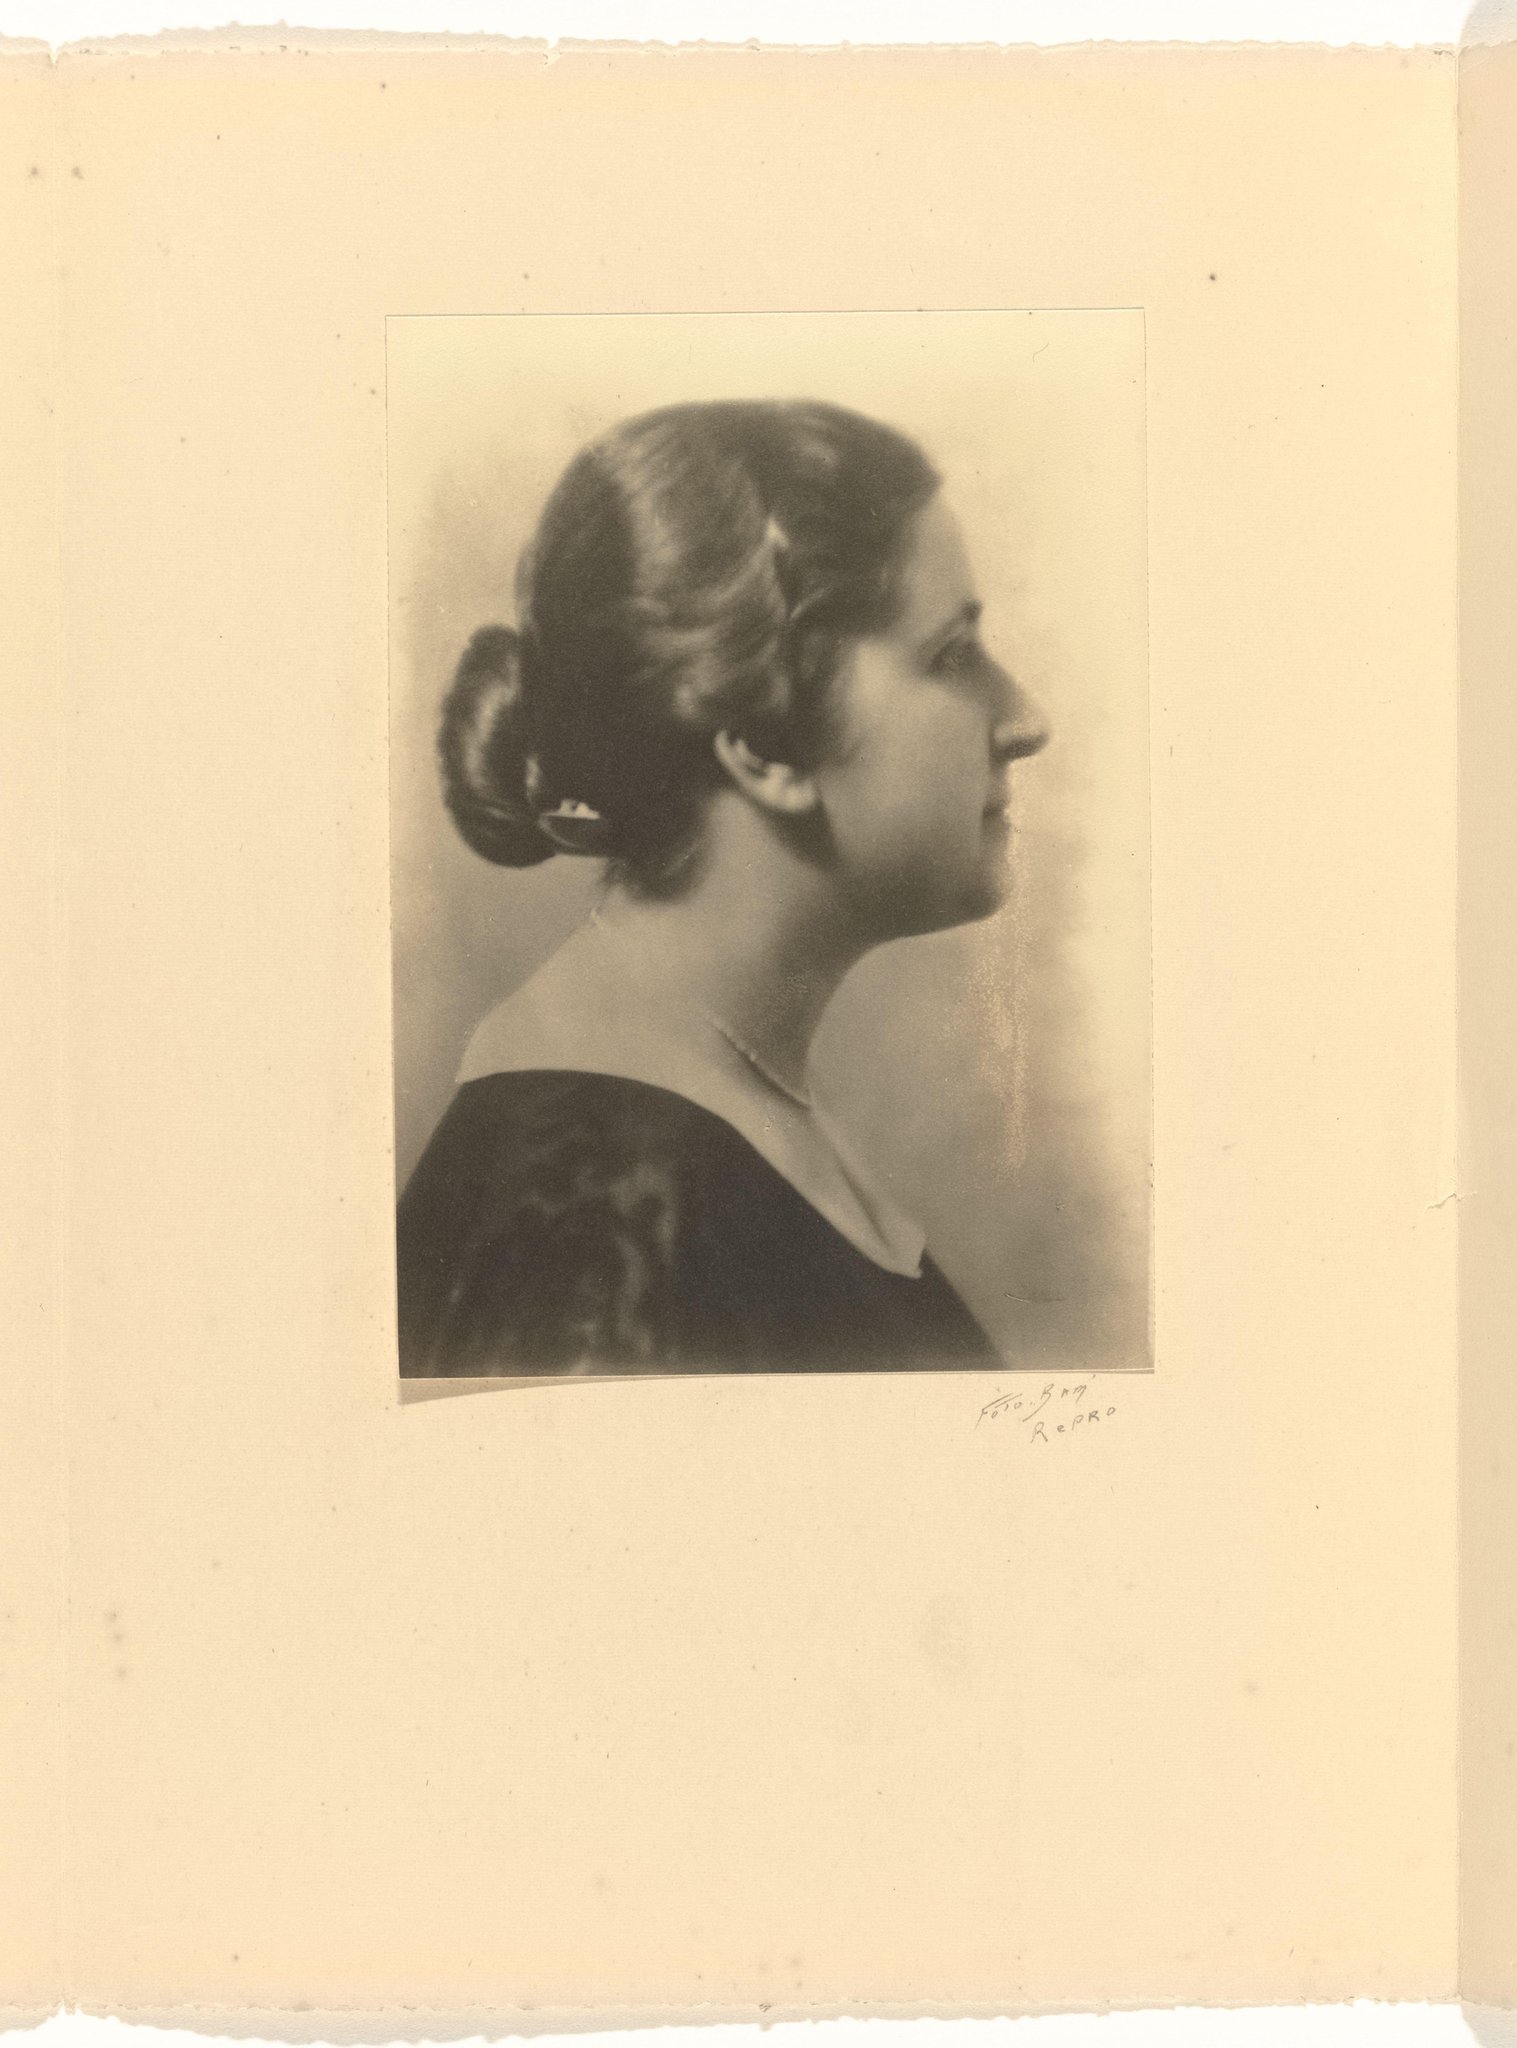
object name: photograph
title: Portret van Else Moos-Wachenheimer in donkere kleding met lichte kraag, Lugano, 1924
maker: Anonymous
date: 1924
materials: photographic support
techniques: gelatin silver print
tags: else wachenheimer-moos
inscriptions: company name: ‘Foto. Bam Repro’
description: Portret van Else Wachenheimer-Moos in donkere kleding met lichte kraag.